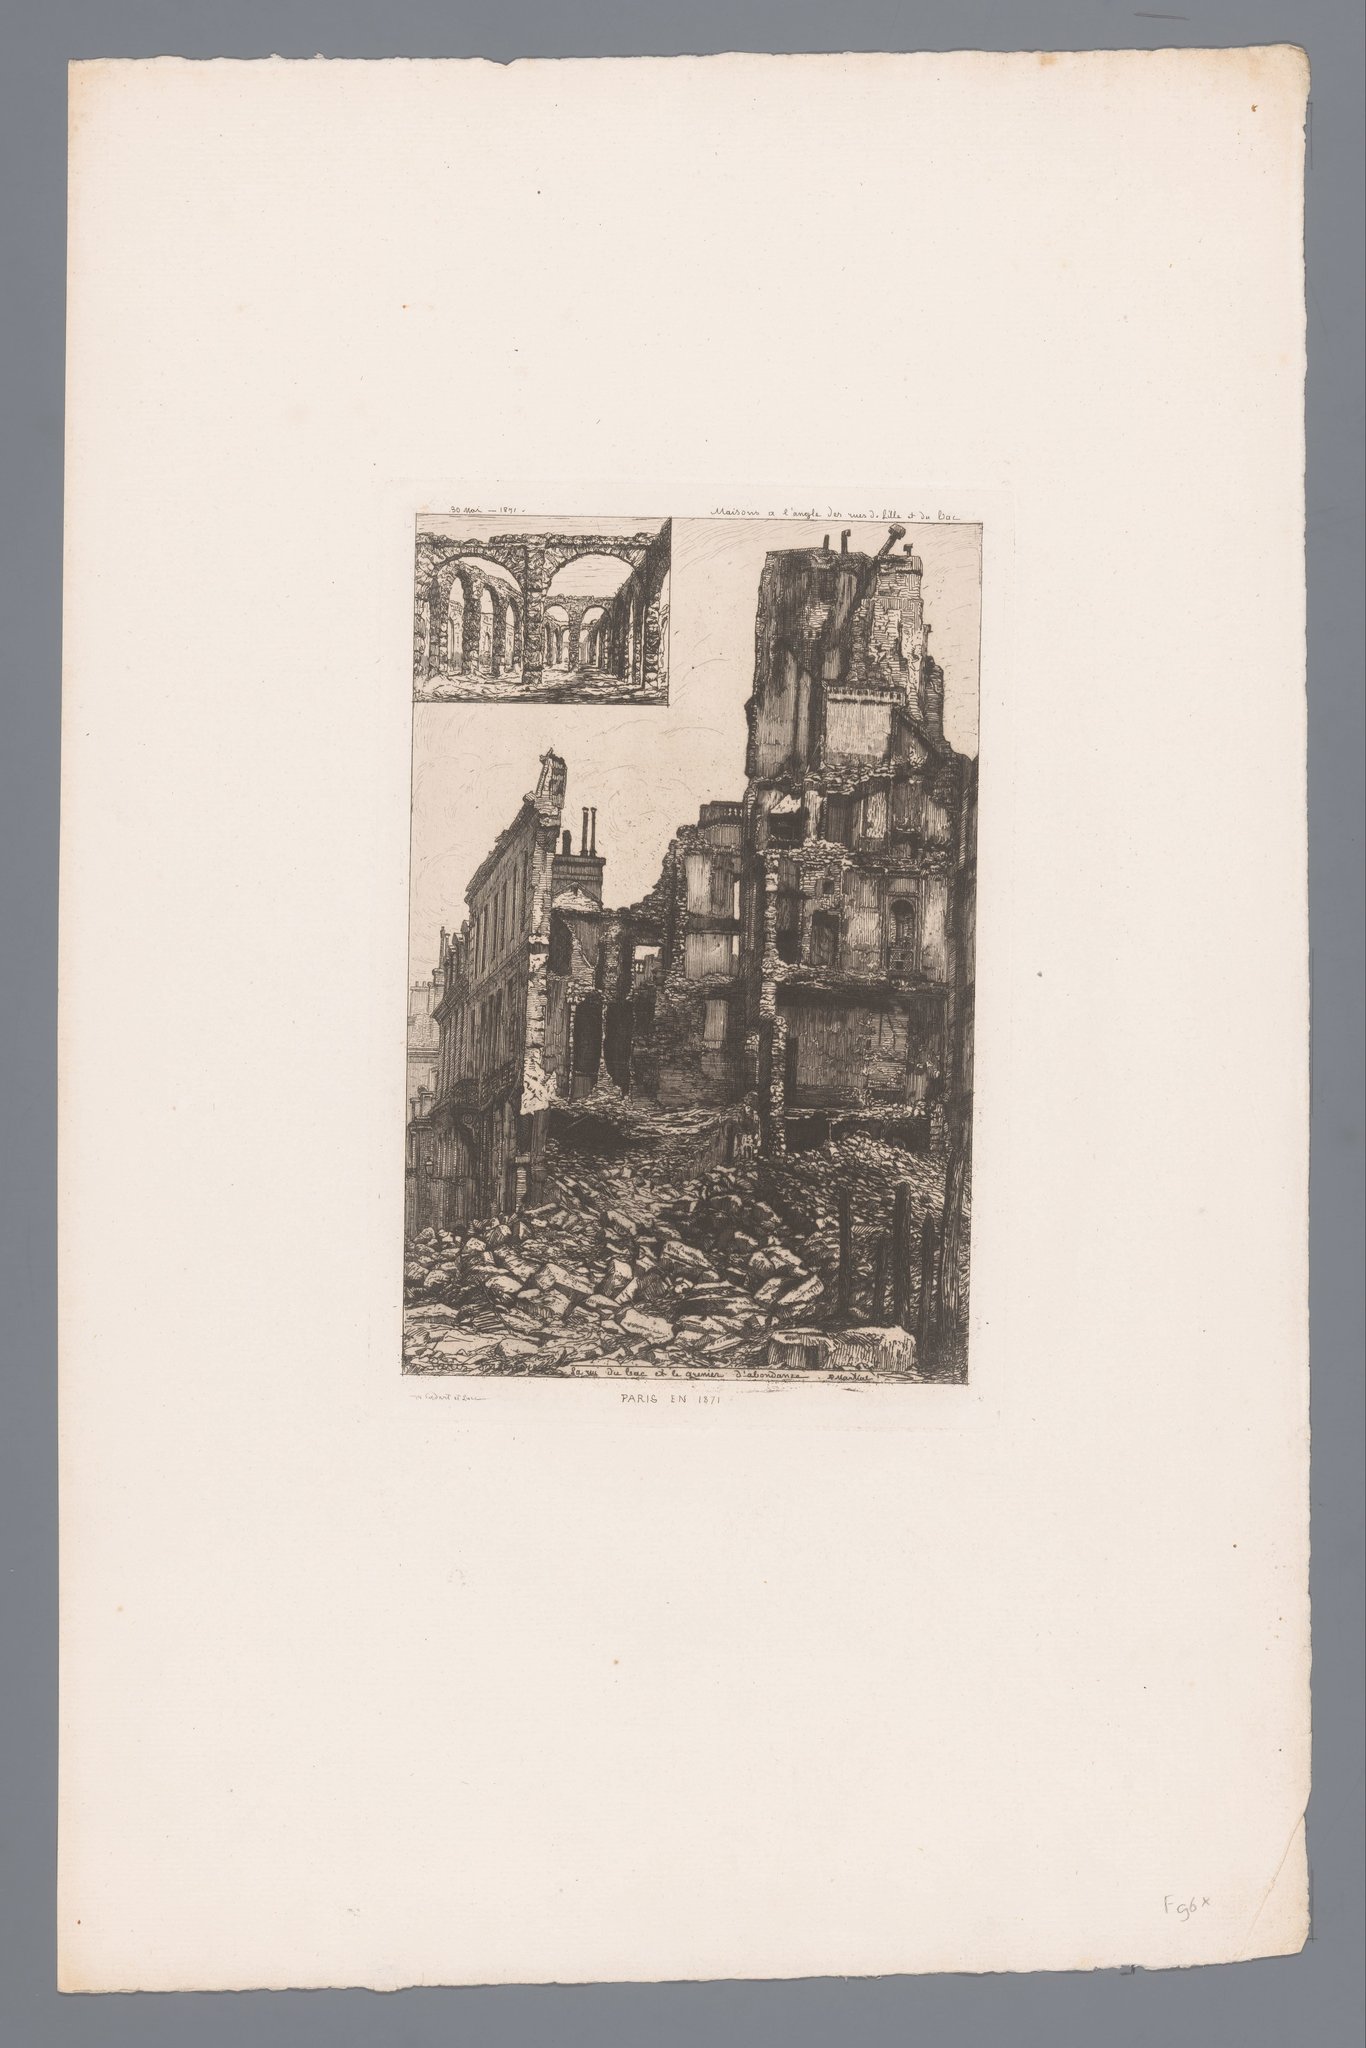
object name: print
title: Paris Incendié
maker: adolphe martial potémont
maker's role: print maker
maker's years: 1828-1883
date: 1871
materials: paper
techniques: etching, intaglio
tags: ruin of a building ~ architecture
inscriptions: collector's mark: Lugt 2228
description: De prent bevindt zich in een omslag en maakt deel uit van een twaalfdelige serie prenten met als onderwerp het brandende Parijs tijdens de Commune in 1871, samengesteld en uitgevoerd door Martial Potémont.